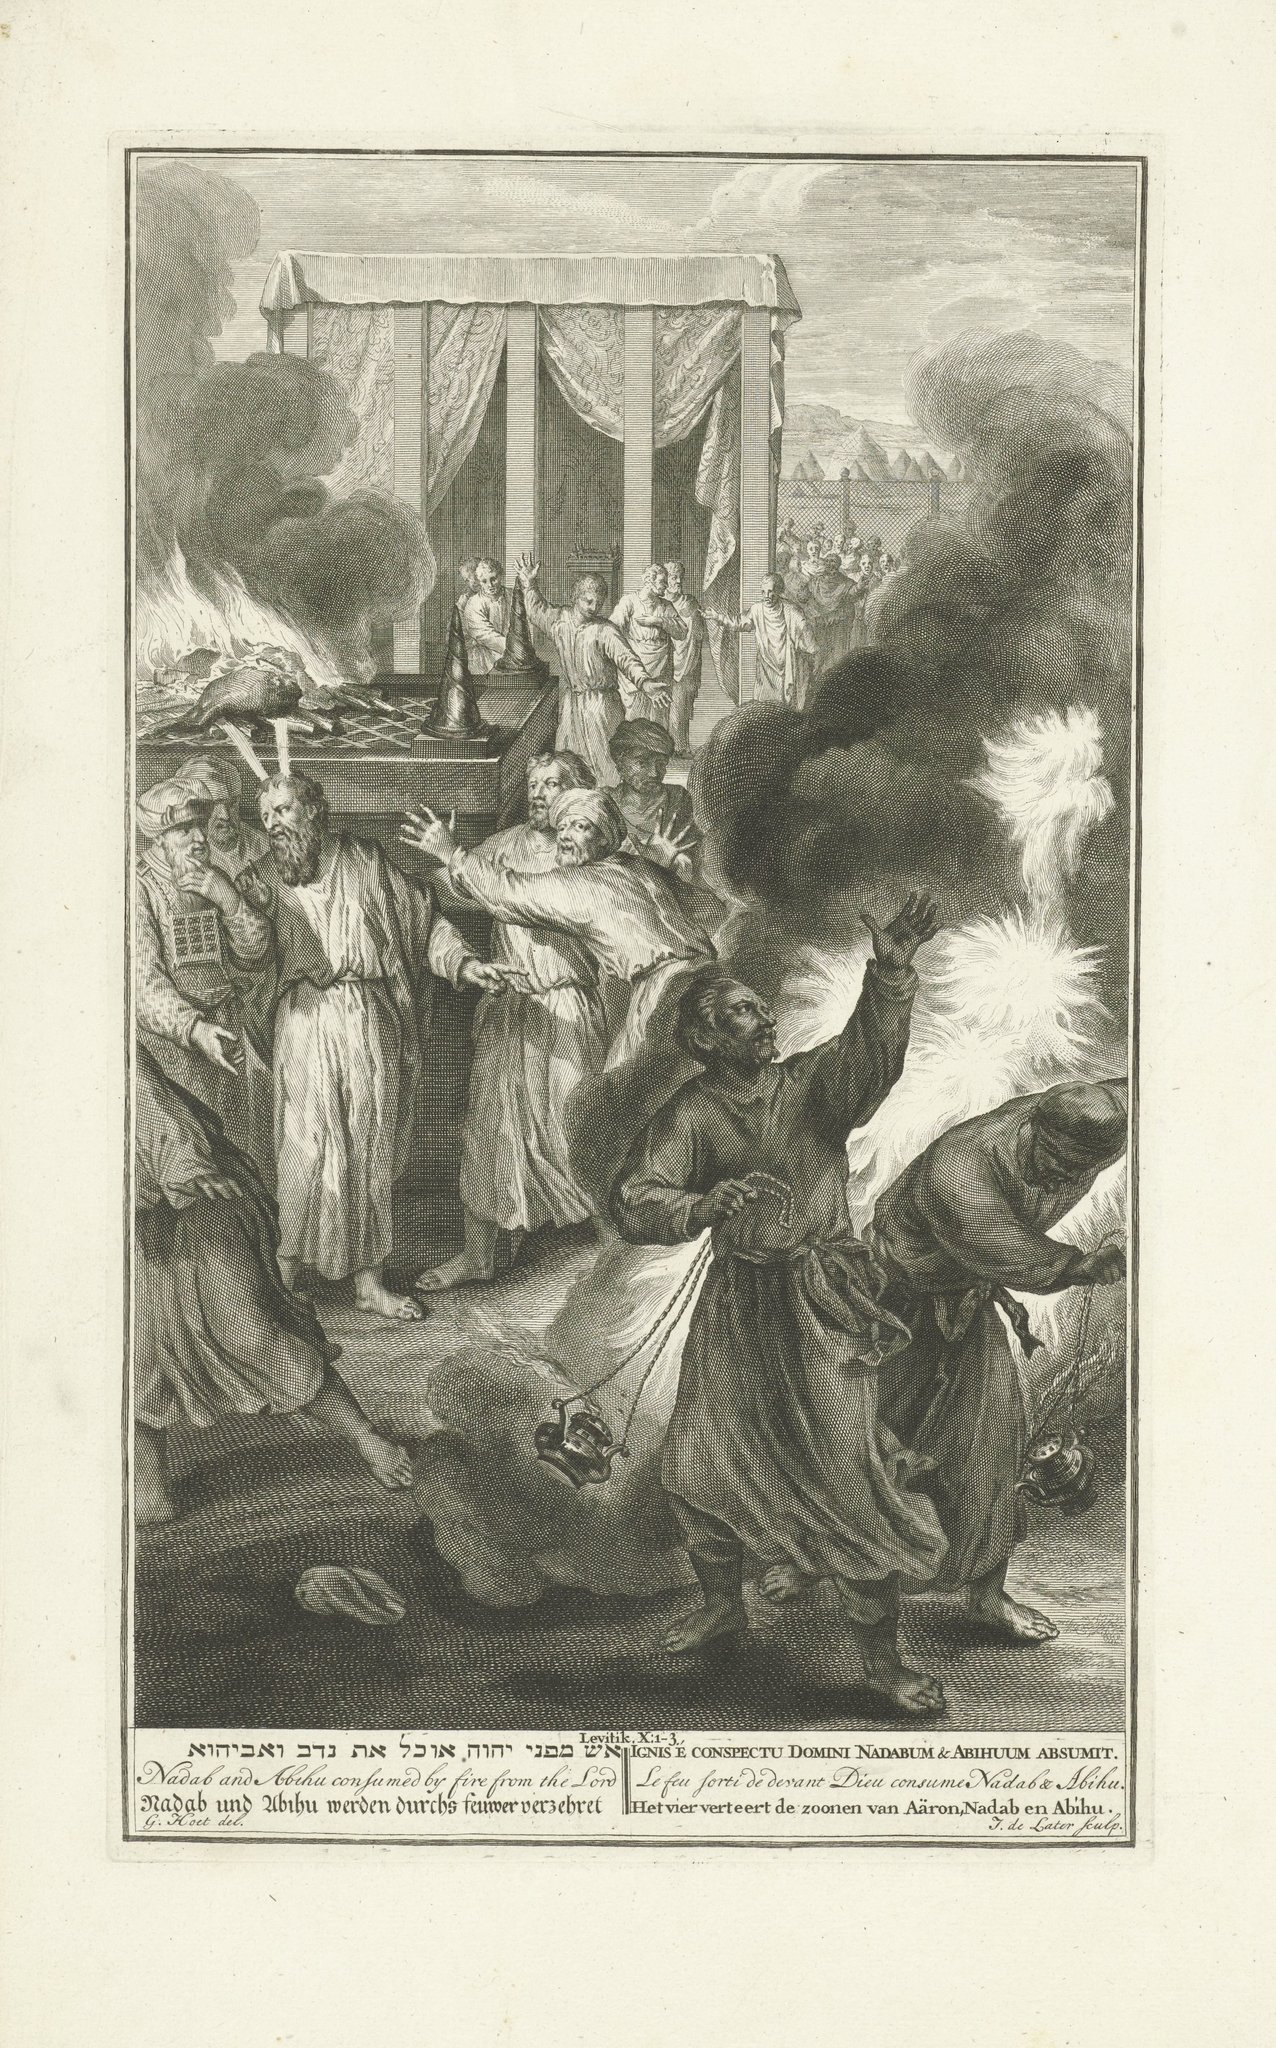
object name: print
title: Nadab en Abihu gedood door vlammen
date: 1728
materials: paper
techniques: engraving, etching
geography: amsterdam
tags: two sons of aaron, nadab and abihu, offer incense in their censers to god, who punishes them for this by sending a fire that kills them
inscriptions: inscription: ‘Utrechts Fundatie huijs’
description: Prent gemaakt voor: Figures de la Bible. Amsterdam, Bernard Picart, 1720. Prent ook gebruikt in: Taferelen der voornaamste geschiedenissen van het Oude en Nieuwe Testament (...) door de vermaarde kunstenaars Hoet, Houbraken, en Picart getekent (...) en met beschrijvingen uitgebreid. Den Haag: Pieter de Hondt, 1728.